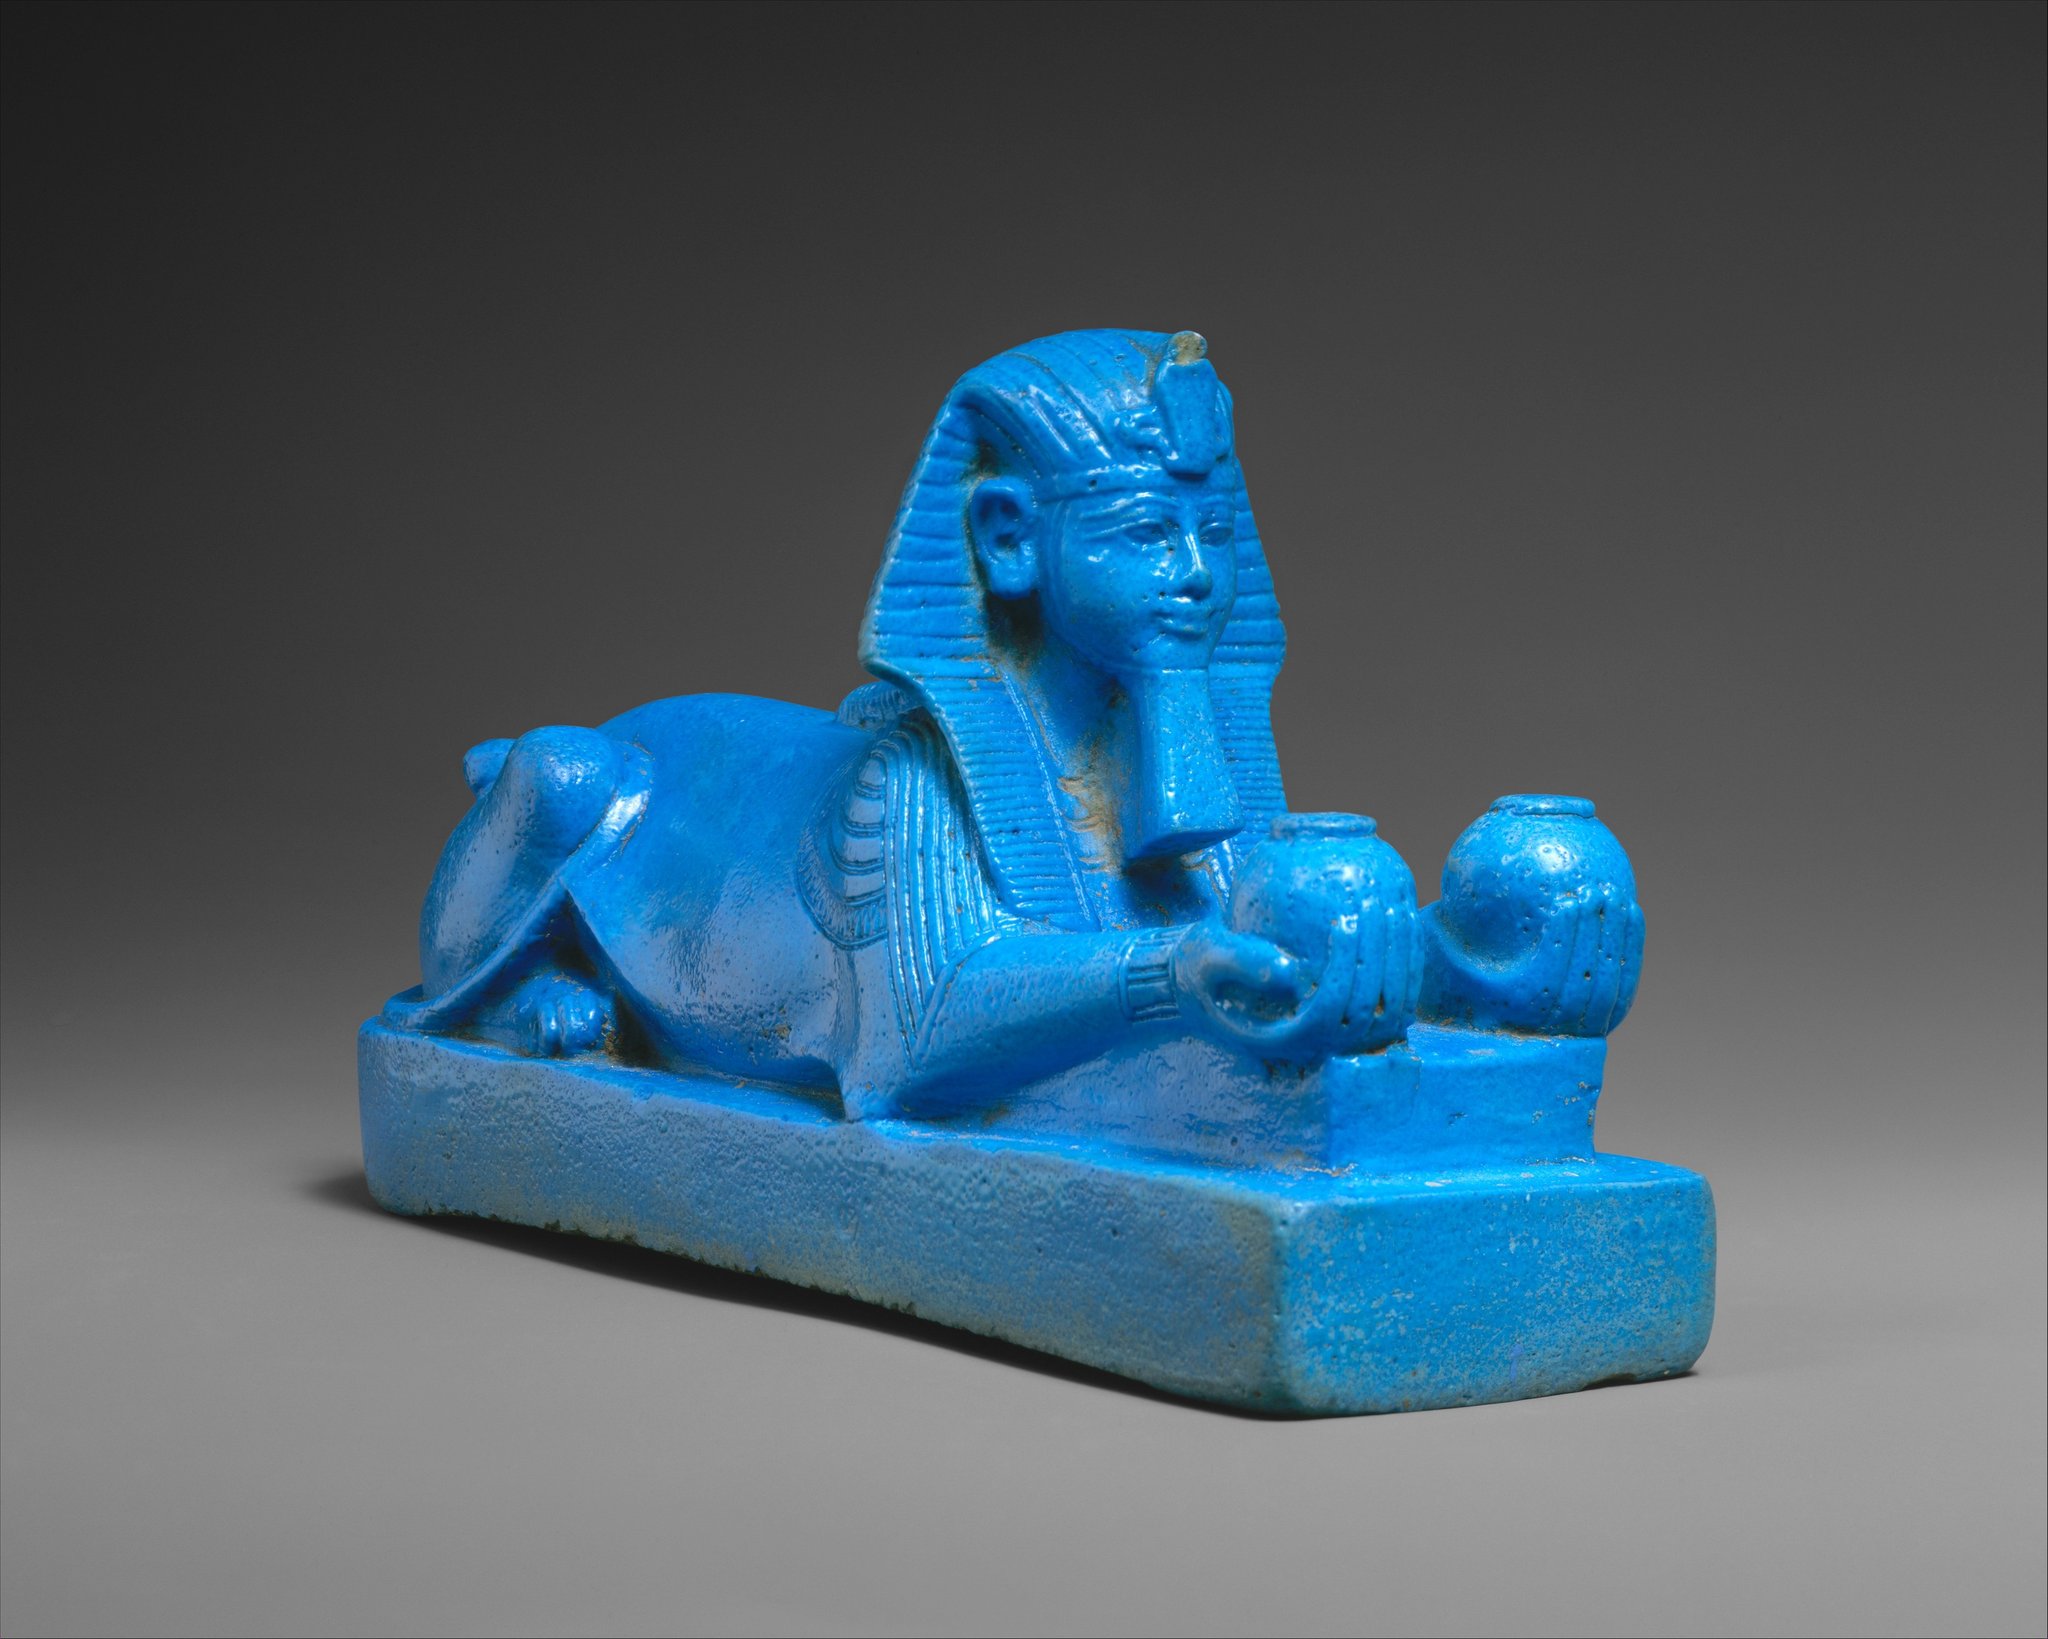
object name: sphinx, amenhotep iii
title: Sphinx of Amenhotep III, possibly from a Model of a Temple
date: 1390-1352 BCE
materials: faience, stone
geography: upper egypt, thebes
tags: sphinx